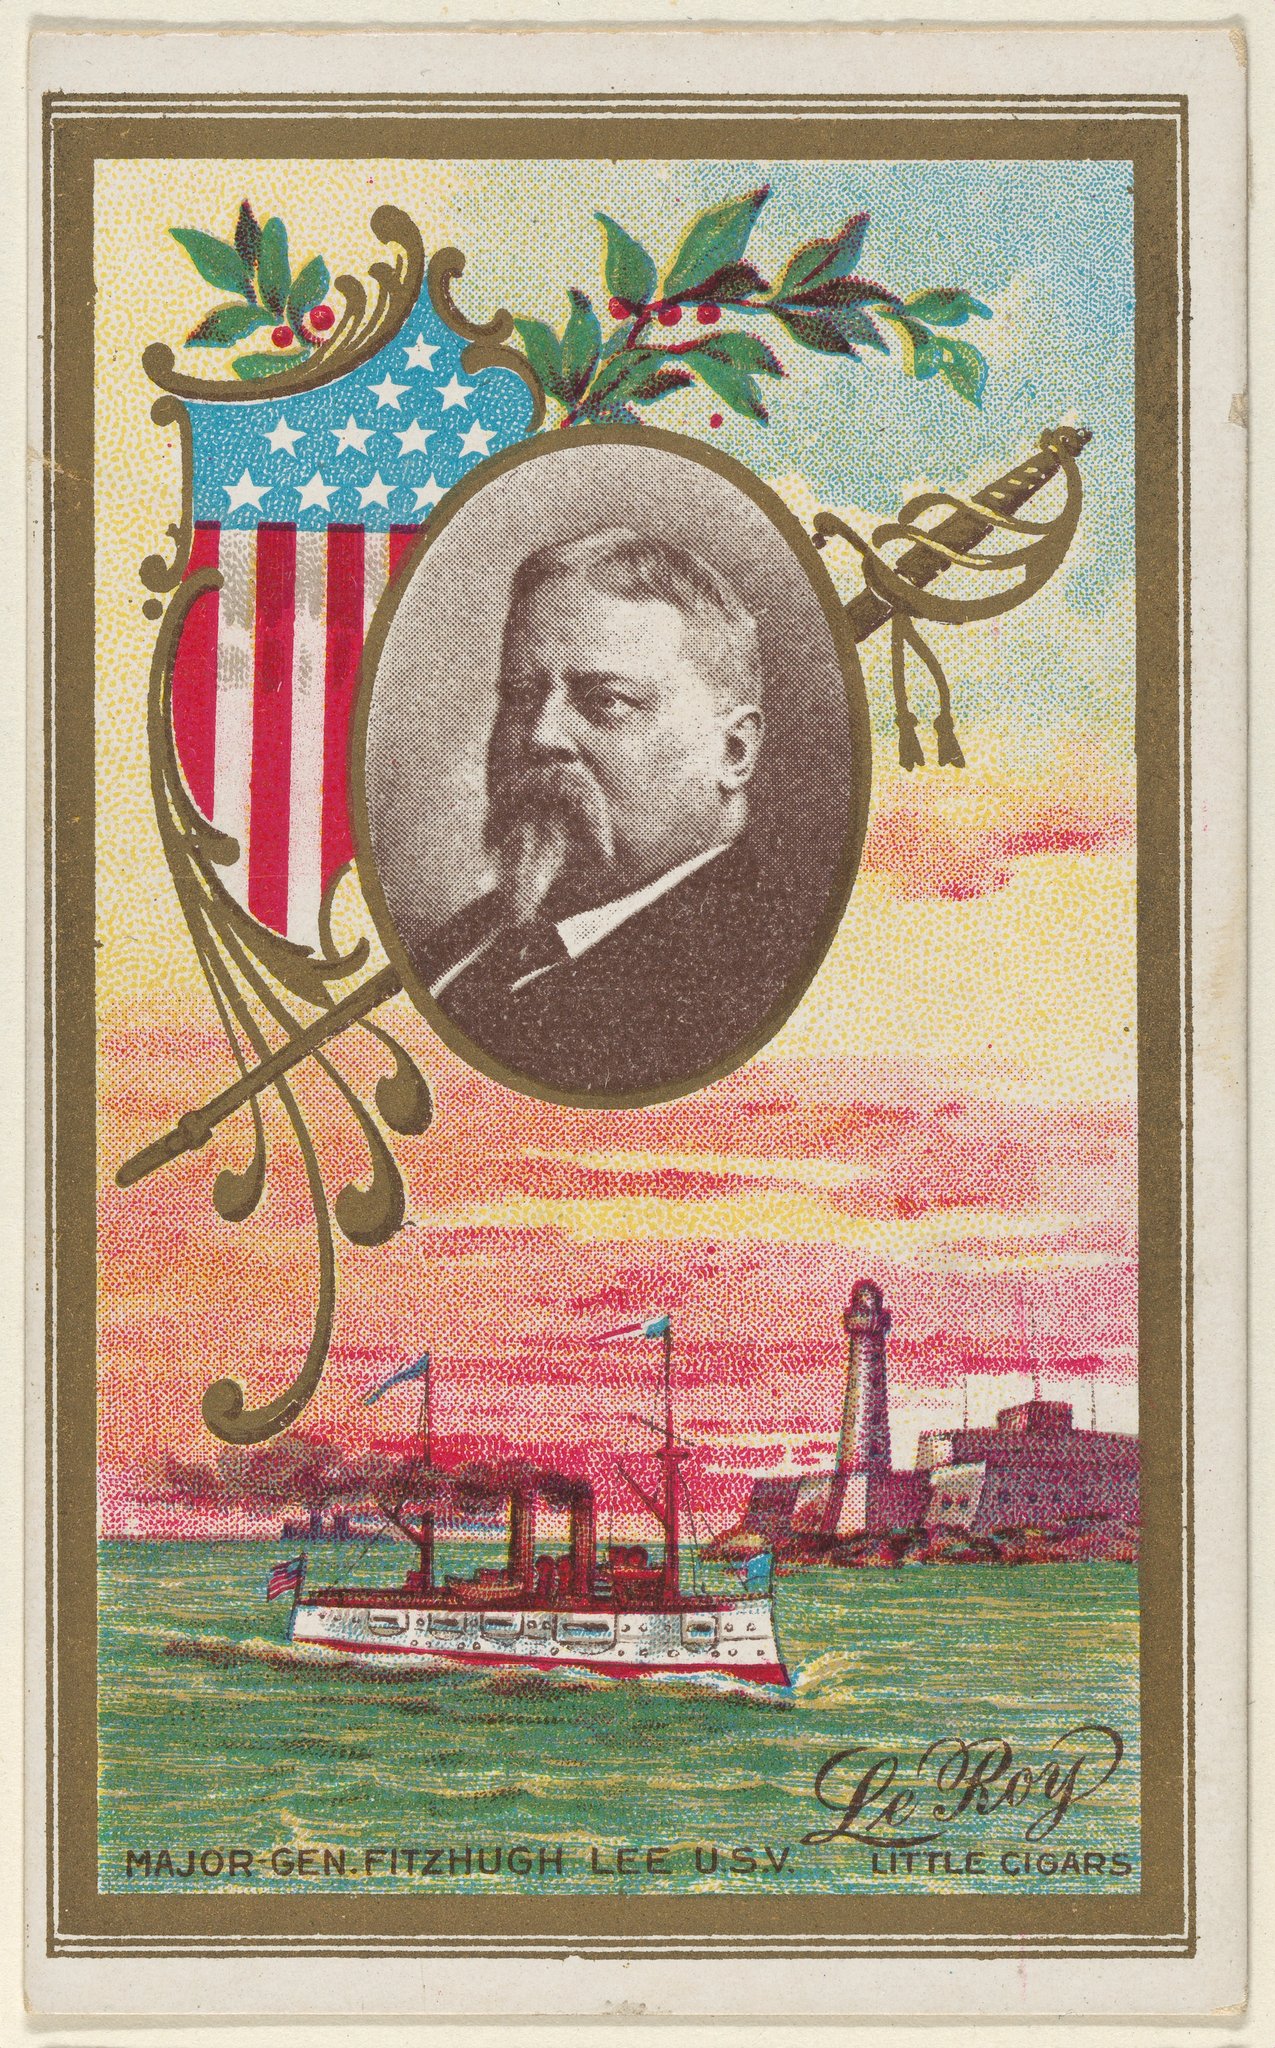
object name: print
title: Major General Fitzhugh Lee, U.S. Volunteers, from the "Generals" series (T63), issued by LeRoy Little Cigars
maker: leroy little cigars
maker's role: publisher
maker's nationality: american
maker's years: 1850-1950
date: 1898-1901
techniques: color lithograph